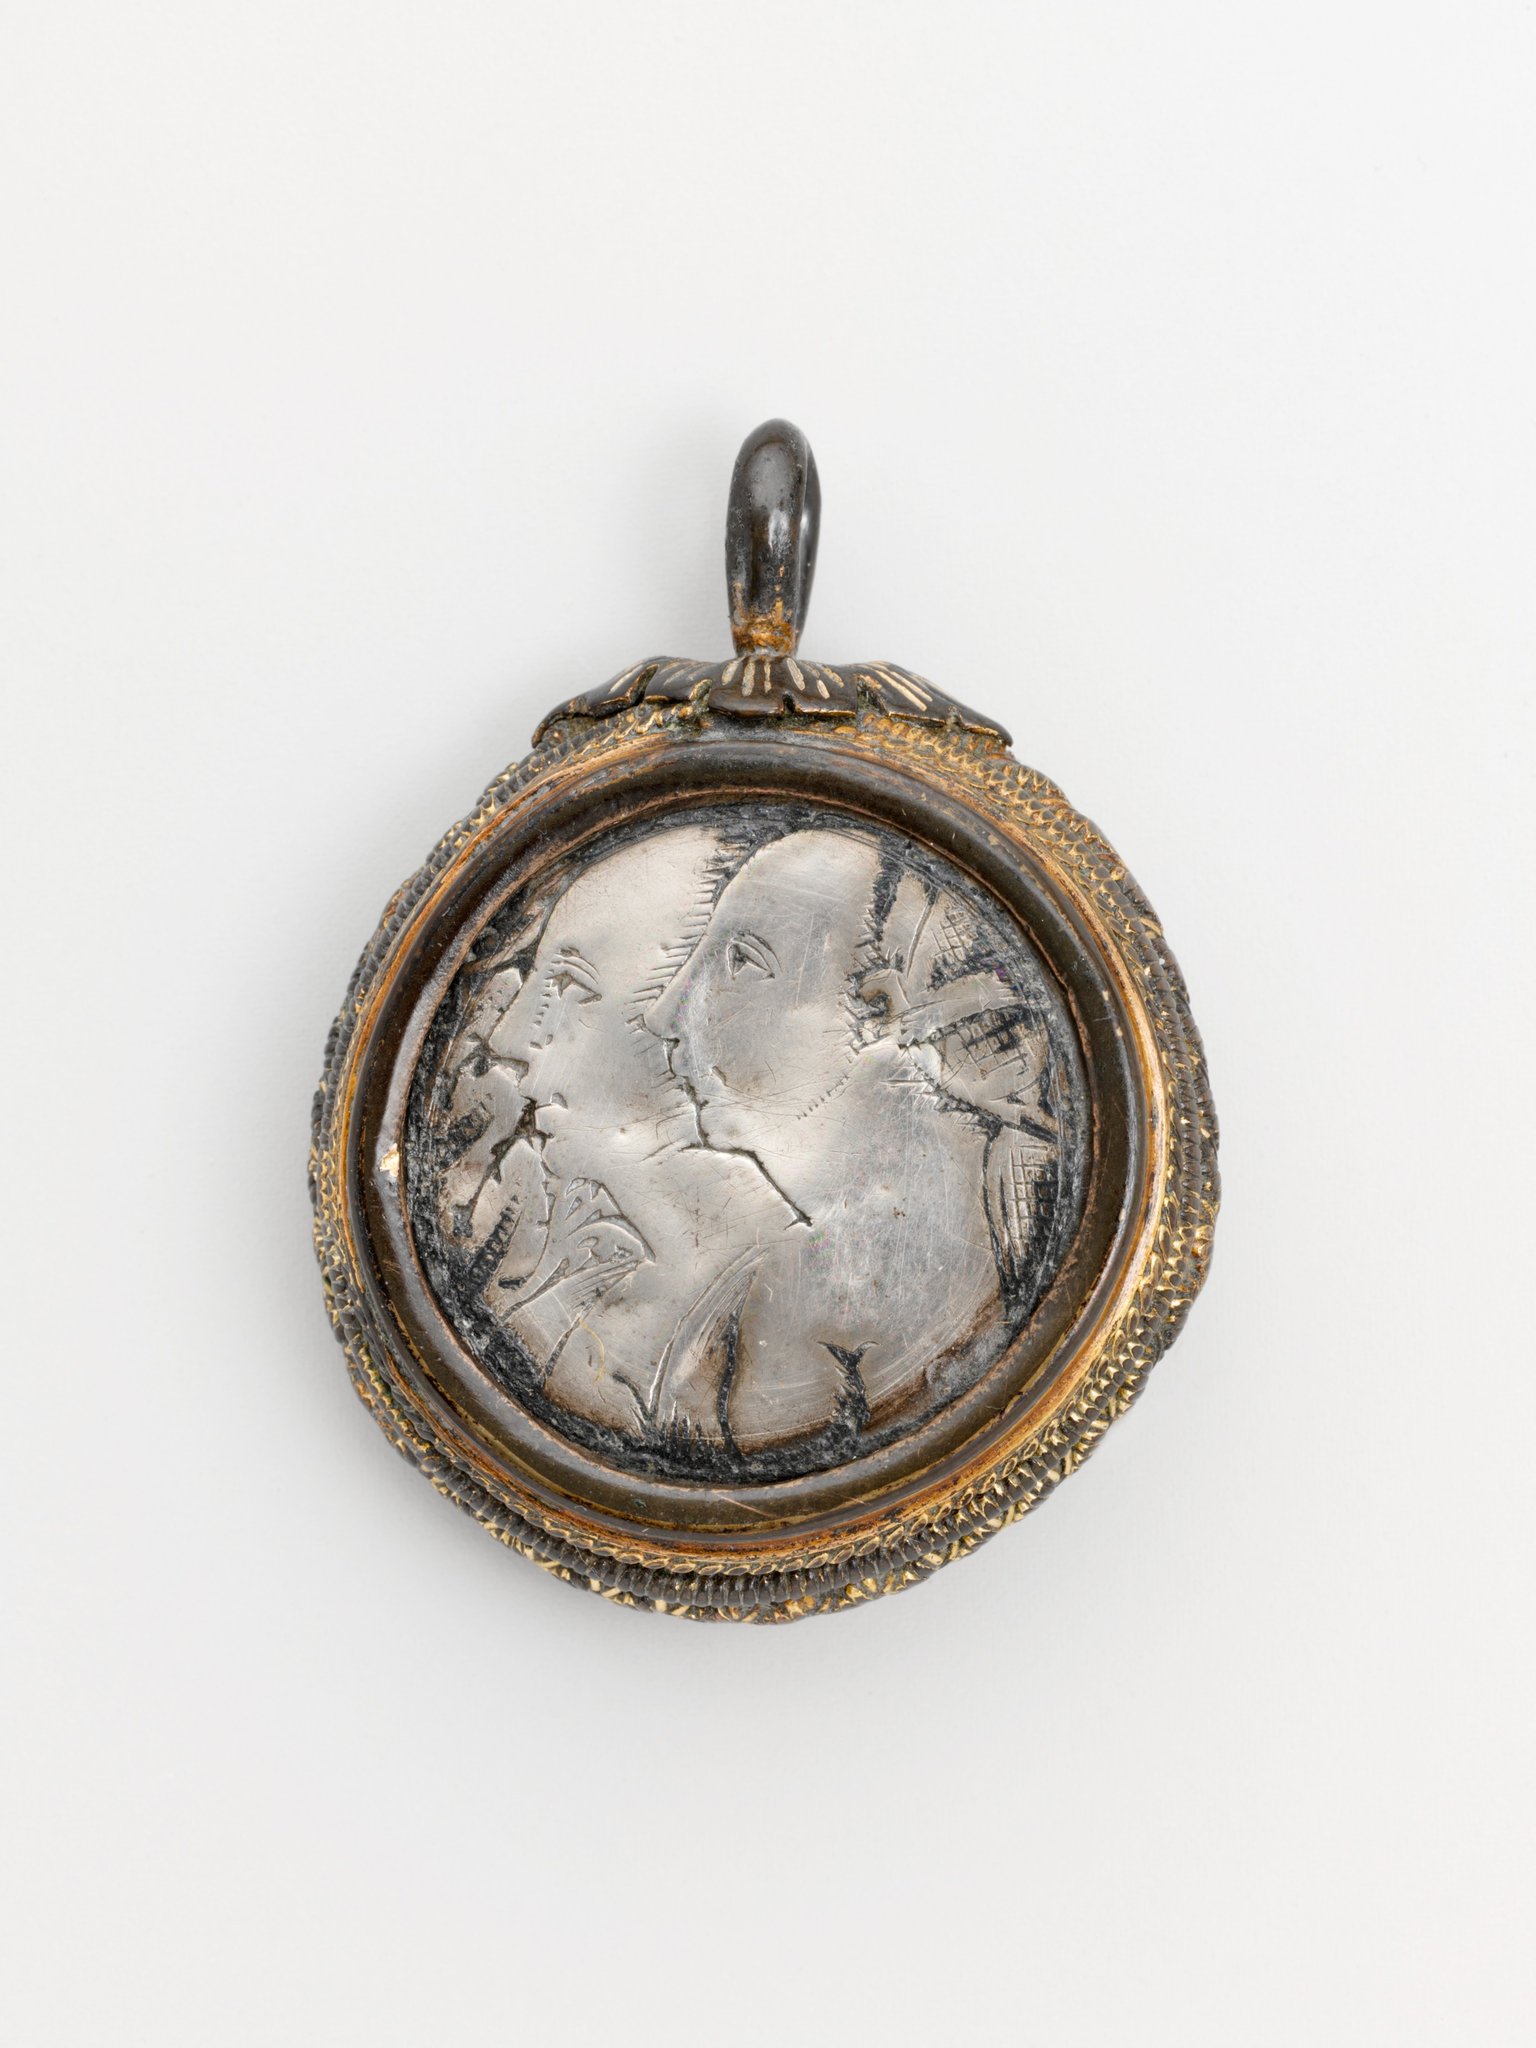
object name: pendant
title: Pendant (one of a pair)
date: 1451-1500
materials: silver gilt, niello, silver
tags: human figures,profiles